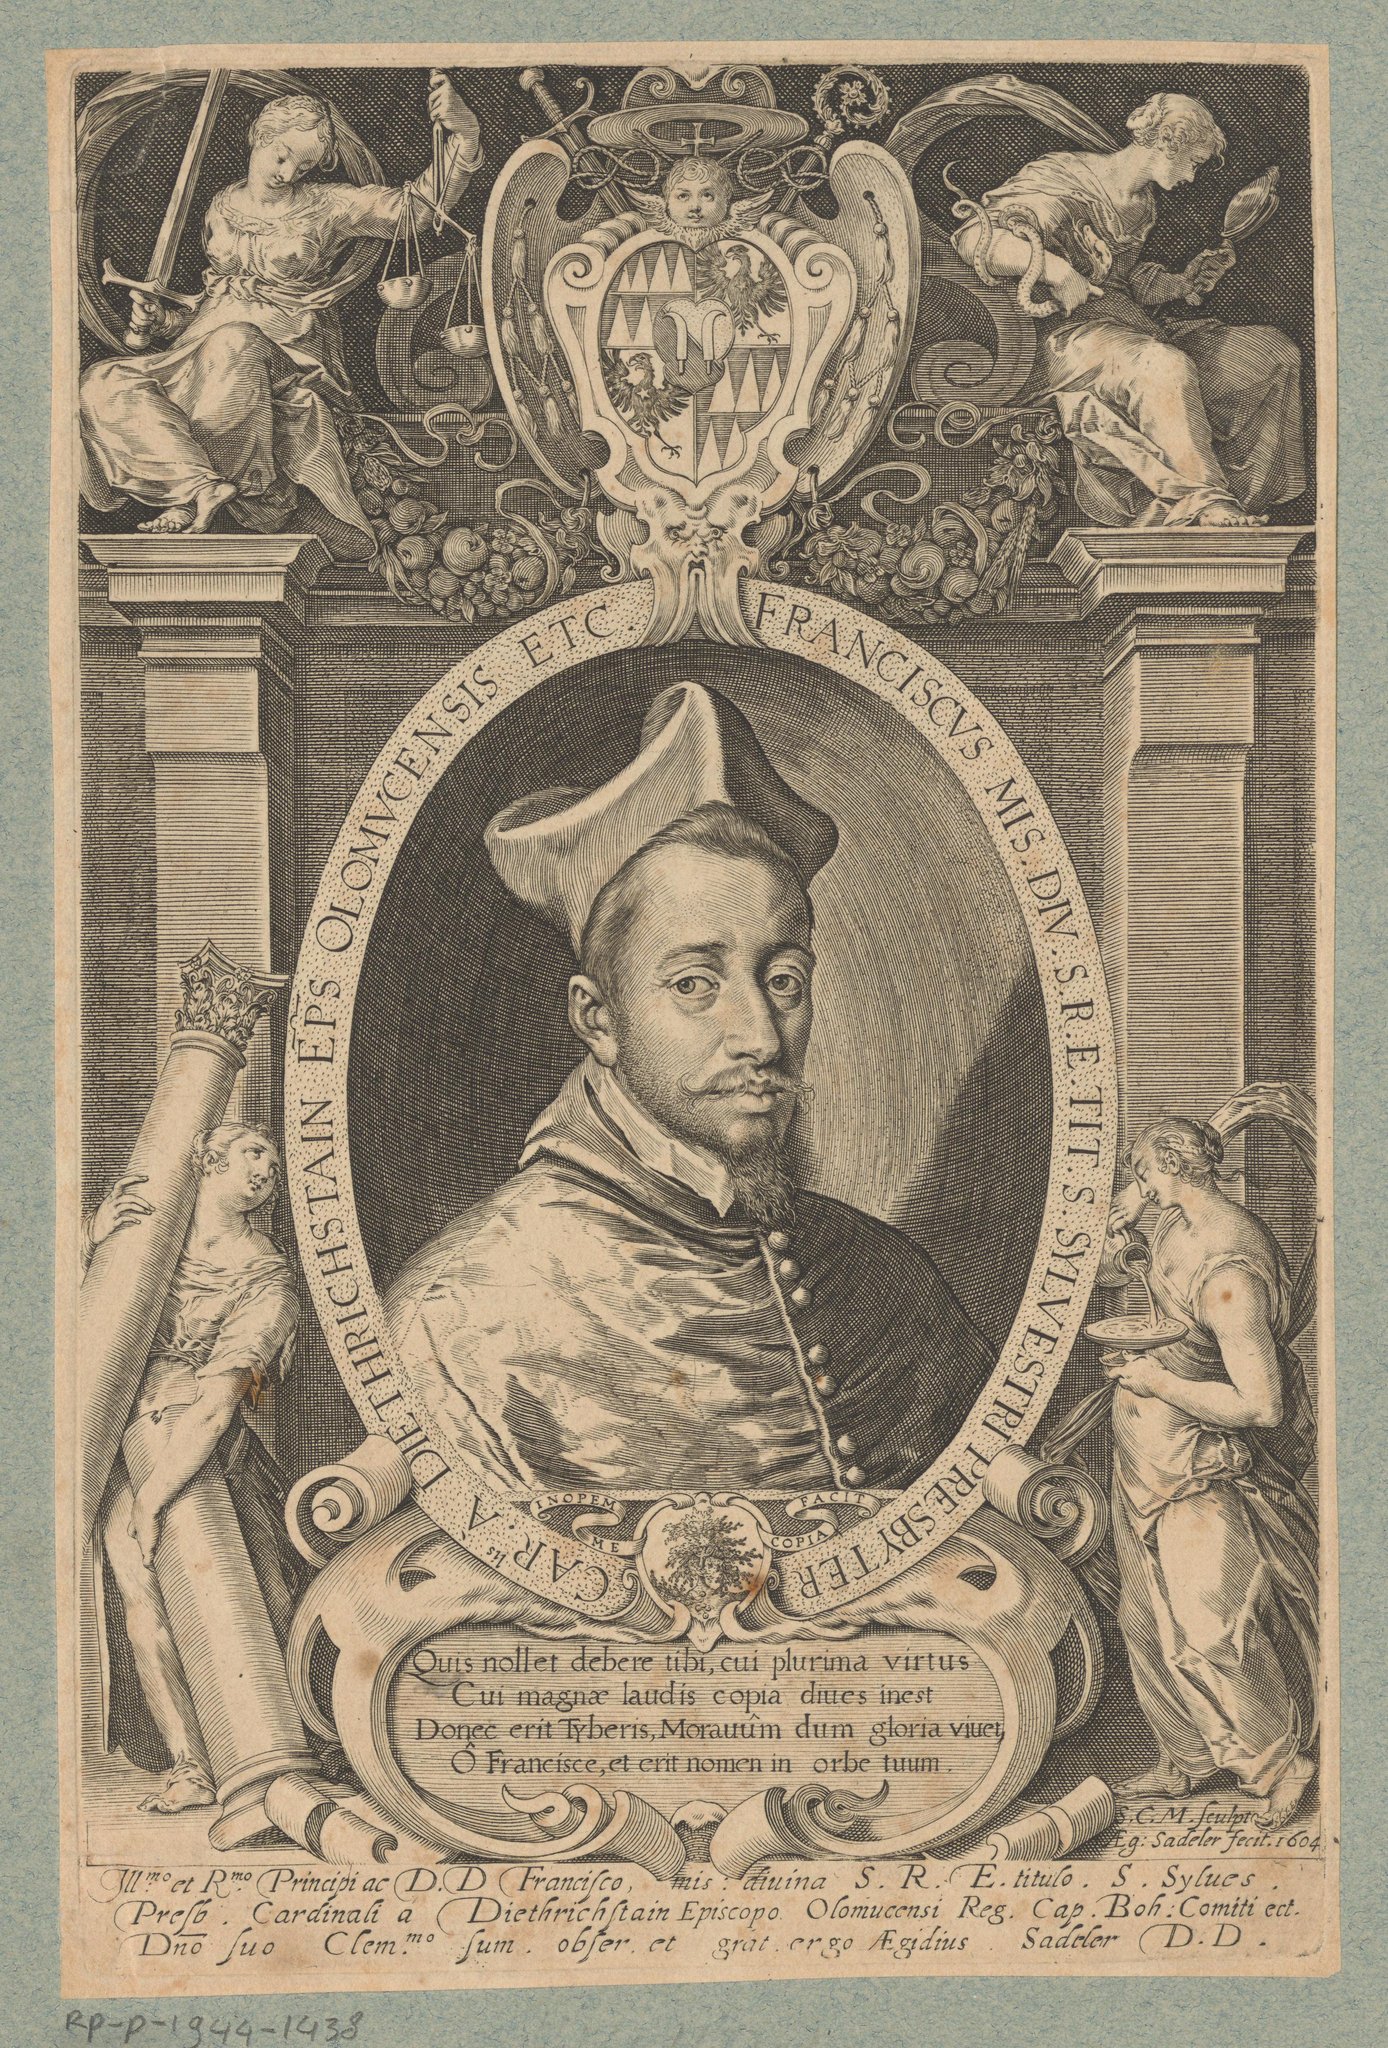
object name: print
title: Portret van Franz Seraph von Dietrichstein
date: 1604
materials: paper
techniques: engraving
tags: franz seraph von dietrichstein, cardinal, historical persons, the four cardinal virtues, armorial bearing, heraldry